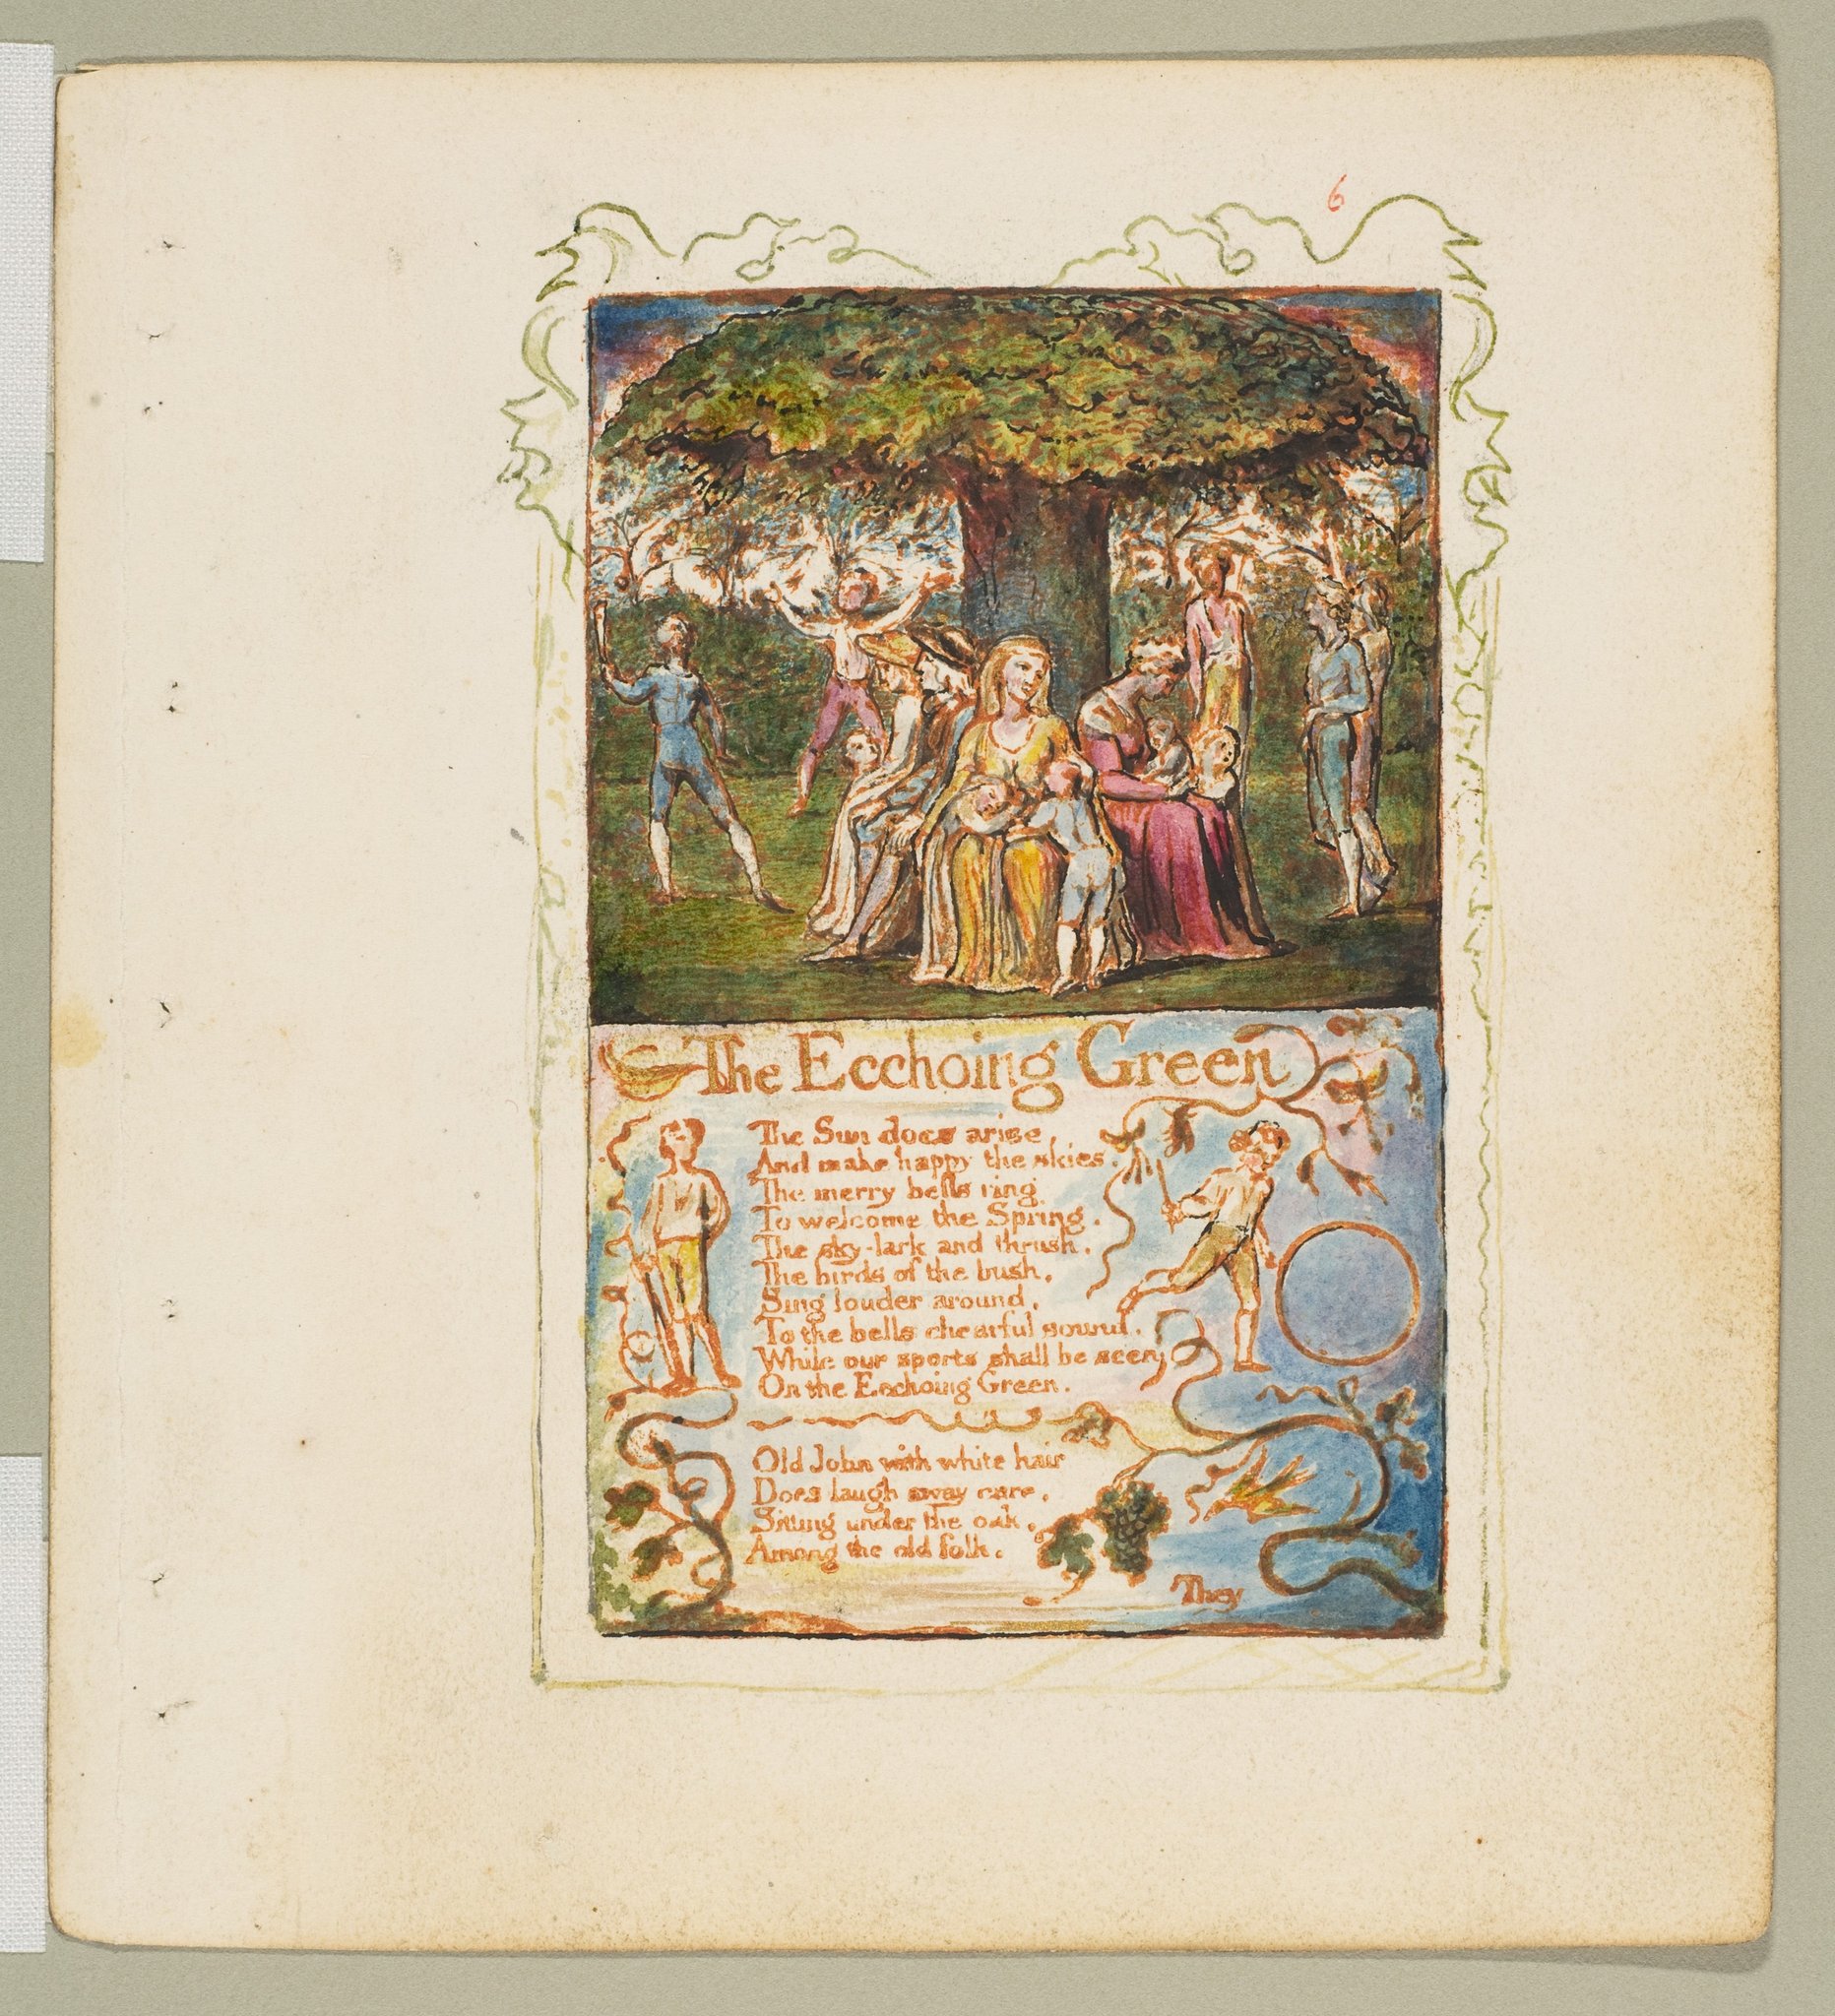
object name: print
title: Songs of Innocence: The Ecchoing Green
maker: william blake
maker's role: artist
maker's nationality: british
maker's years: 1757-1827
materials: gold, ink, shell, watercolor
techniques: etching, hand coloring, printing, relief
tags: poetry,children,women